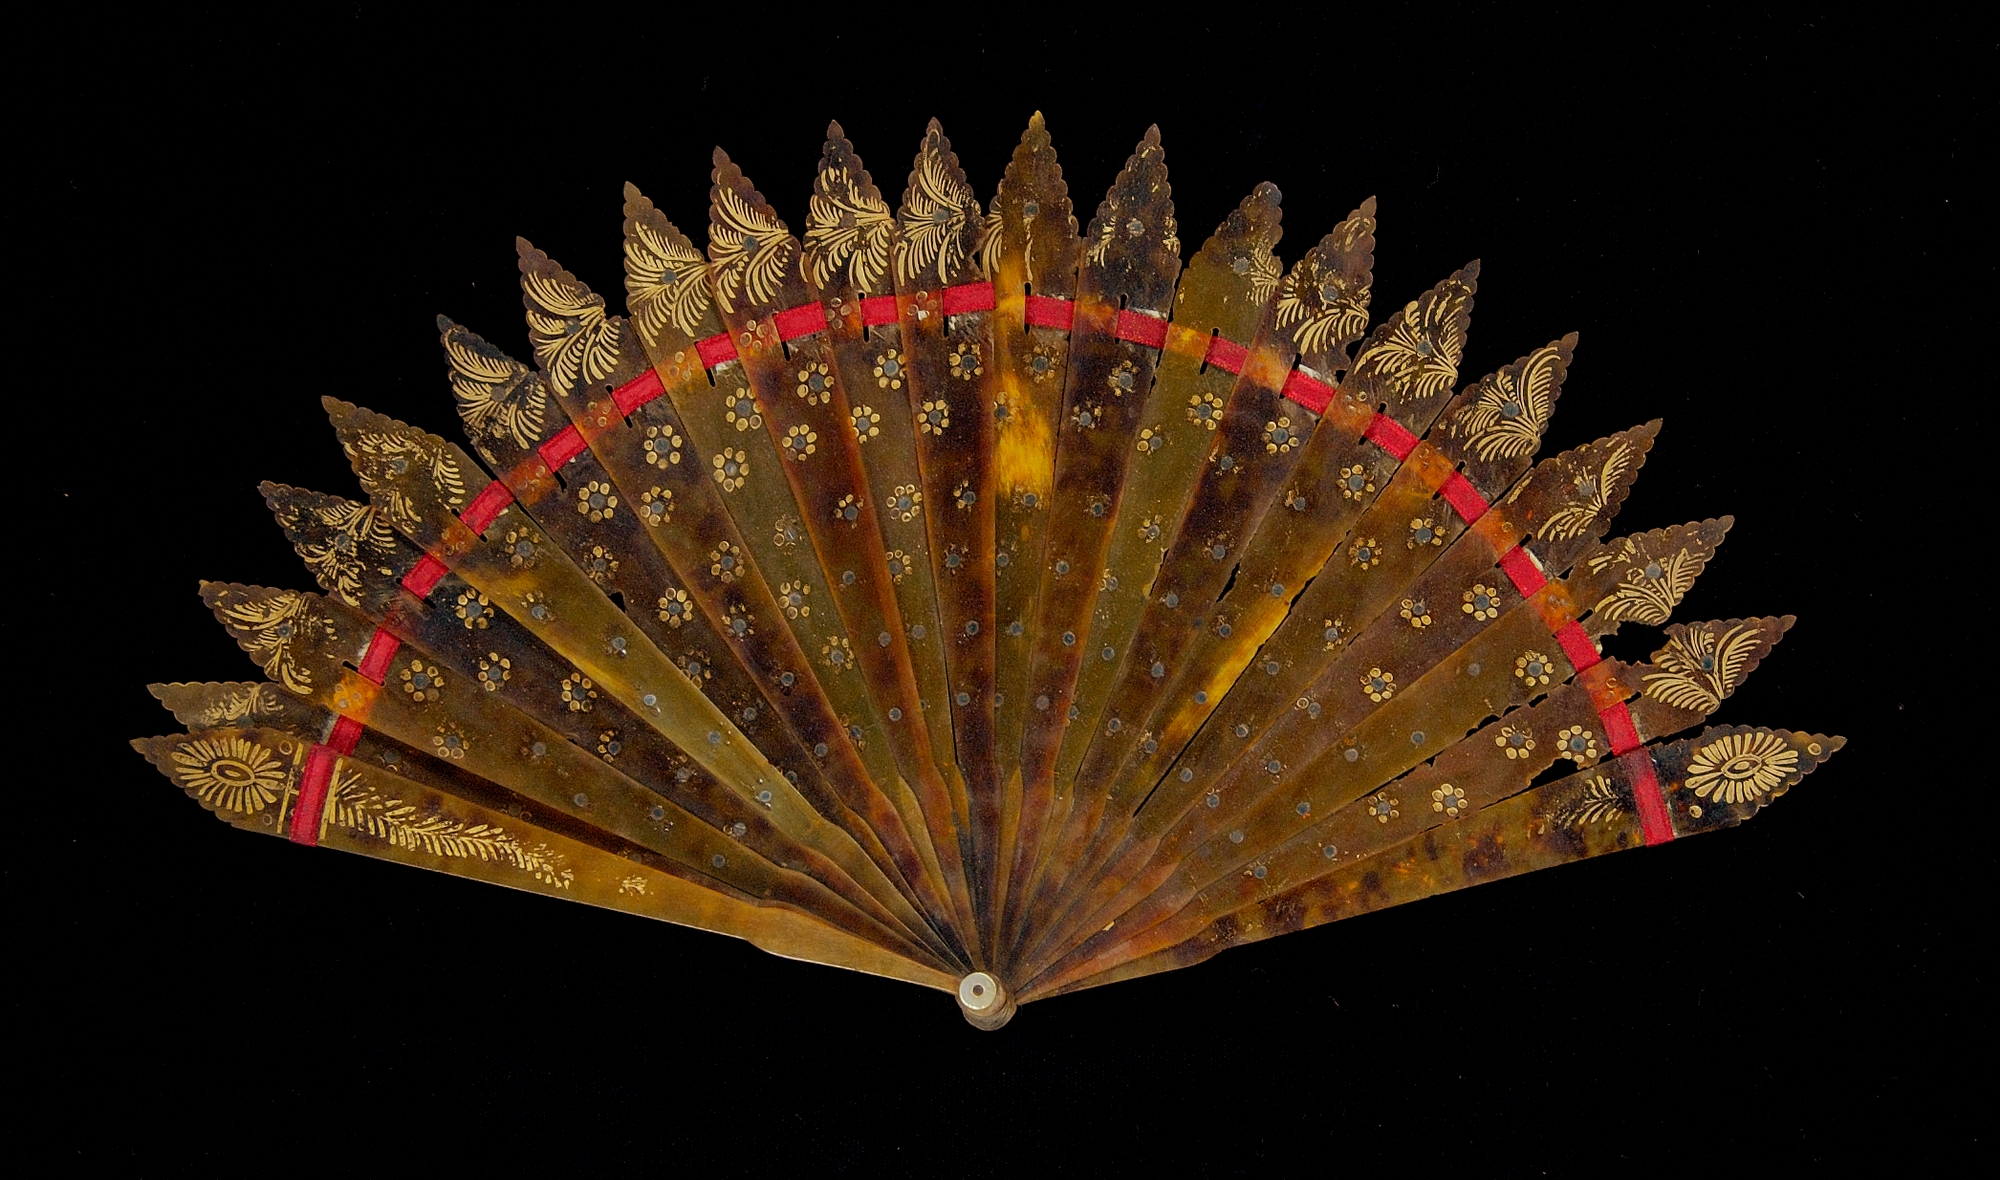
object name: brisé fan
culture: british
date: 1820-1829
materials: horn, mother of pearl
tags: flowers